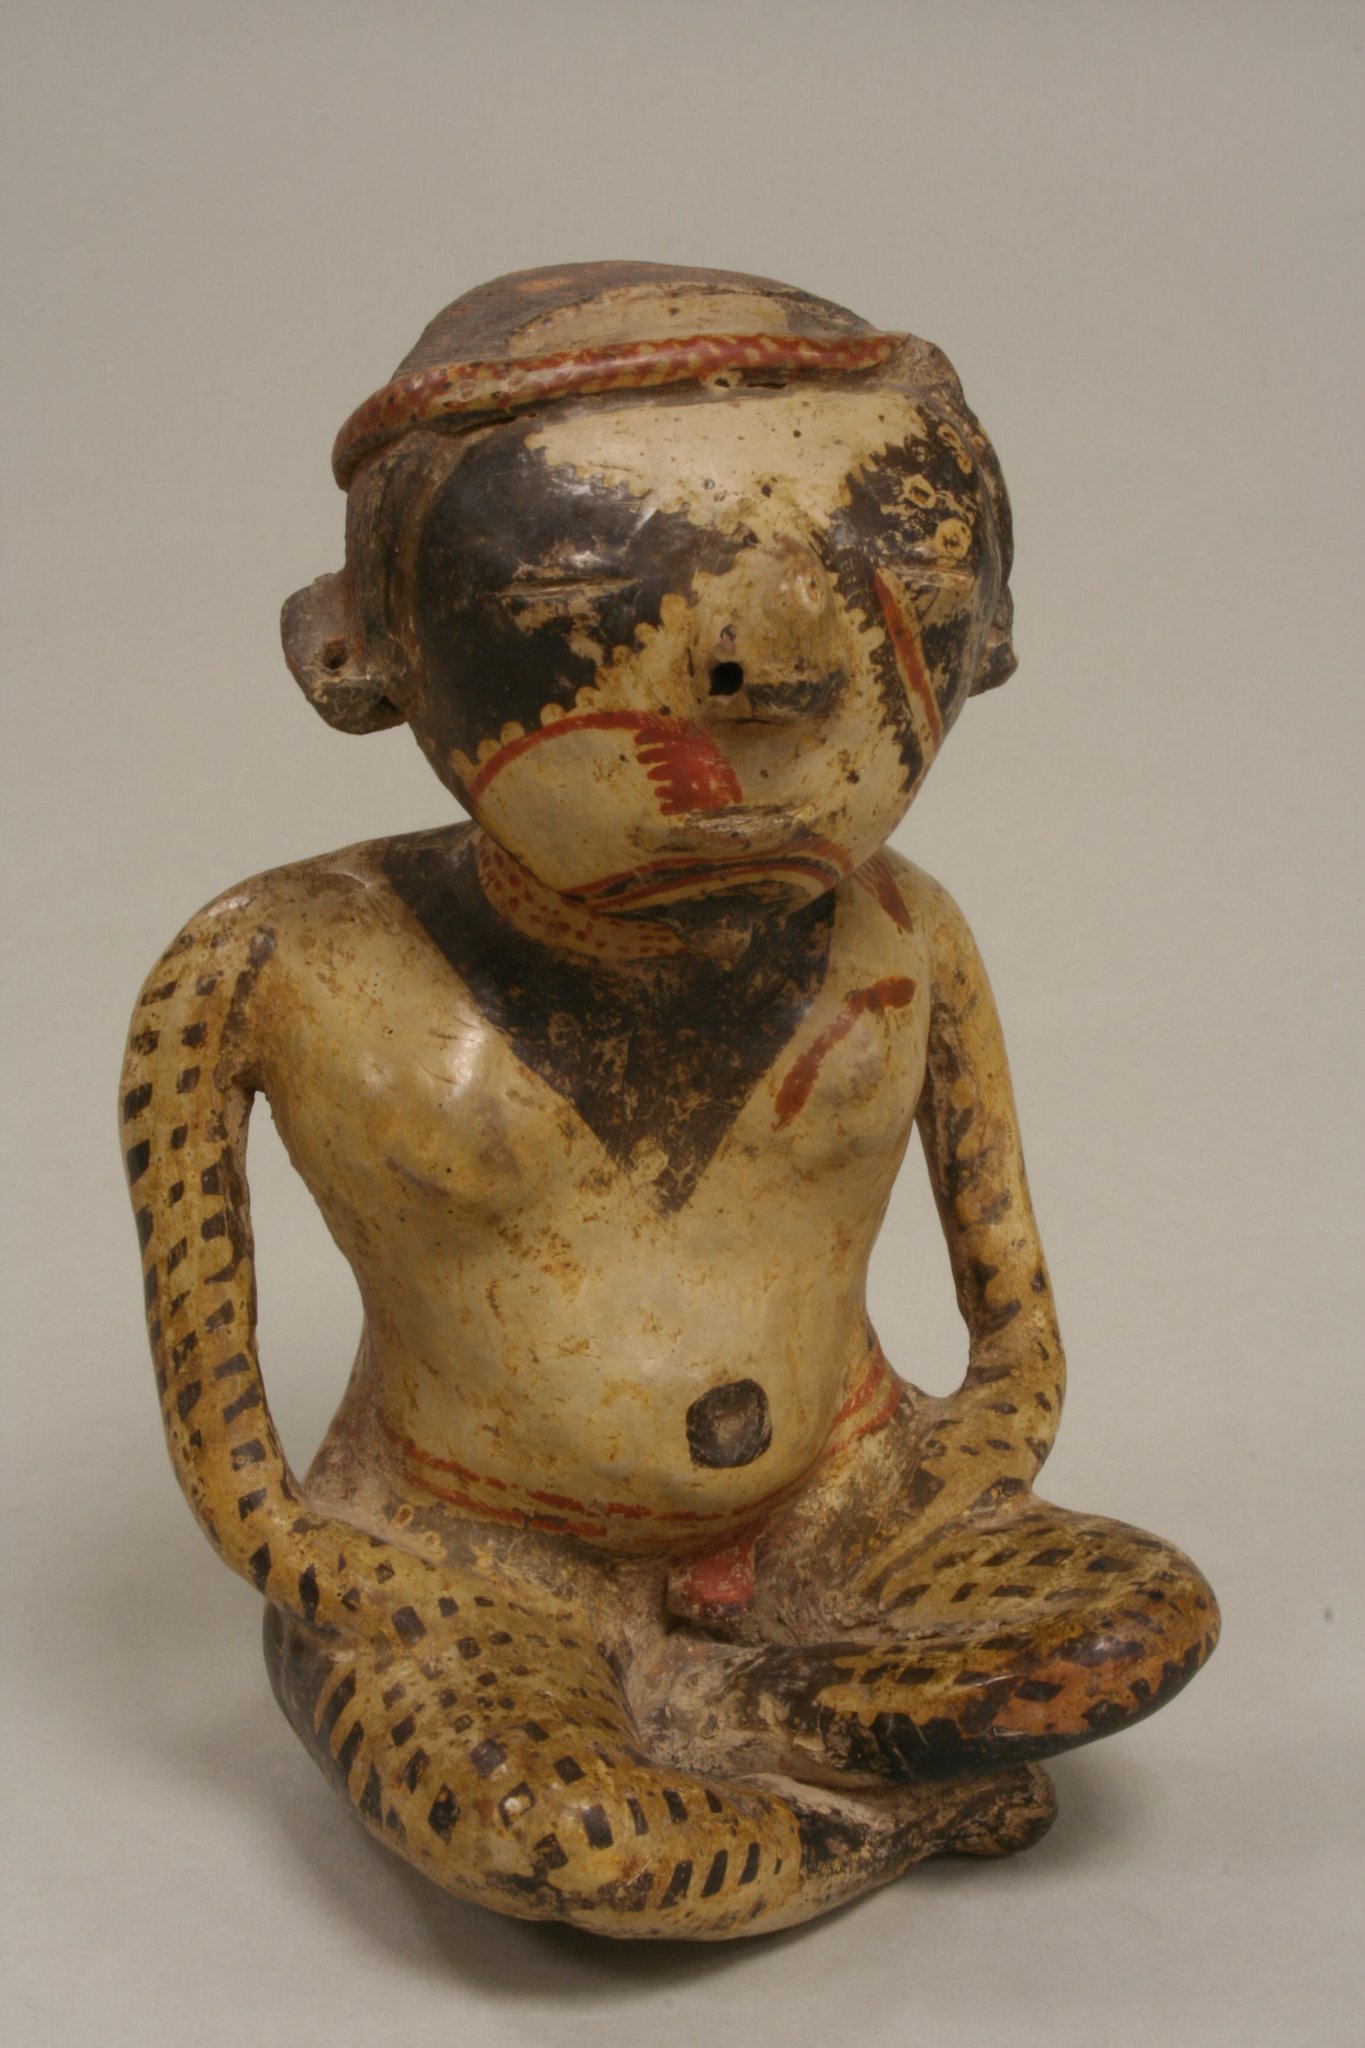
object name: male figure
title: Seated Male Figure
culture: nayarit, chinesco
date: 101-400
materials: ceramic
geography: mexico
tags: men